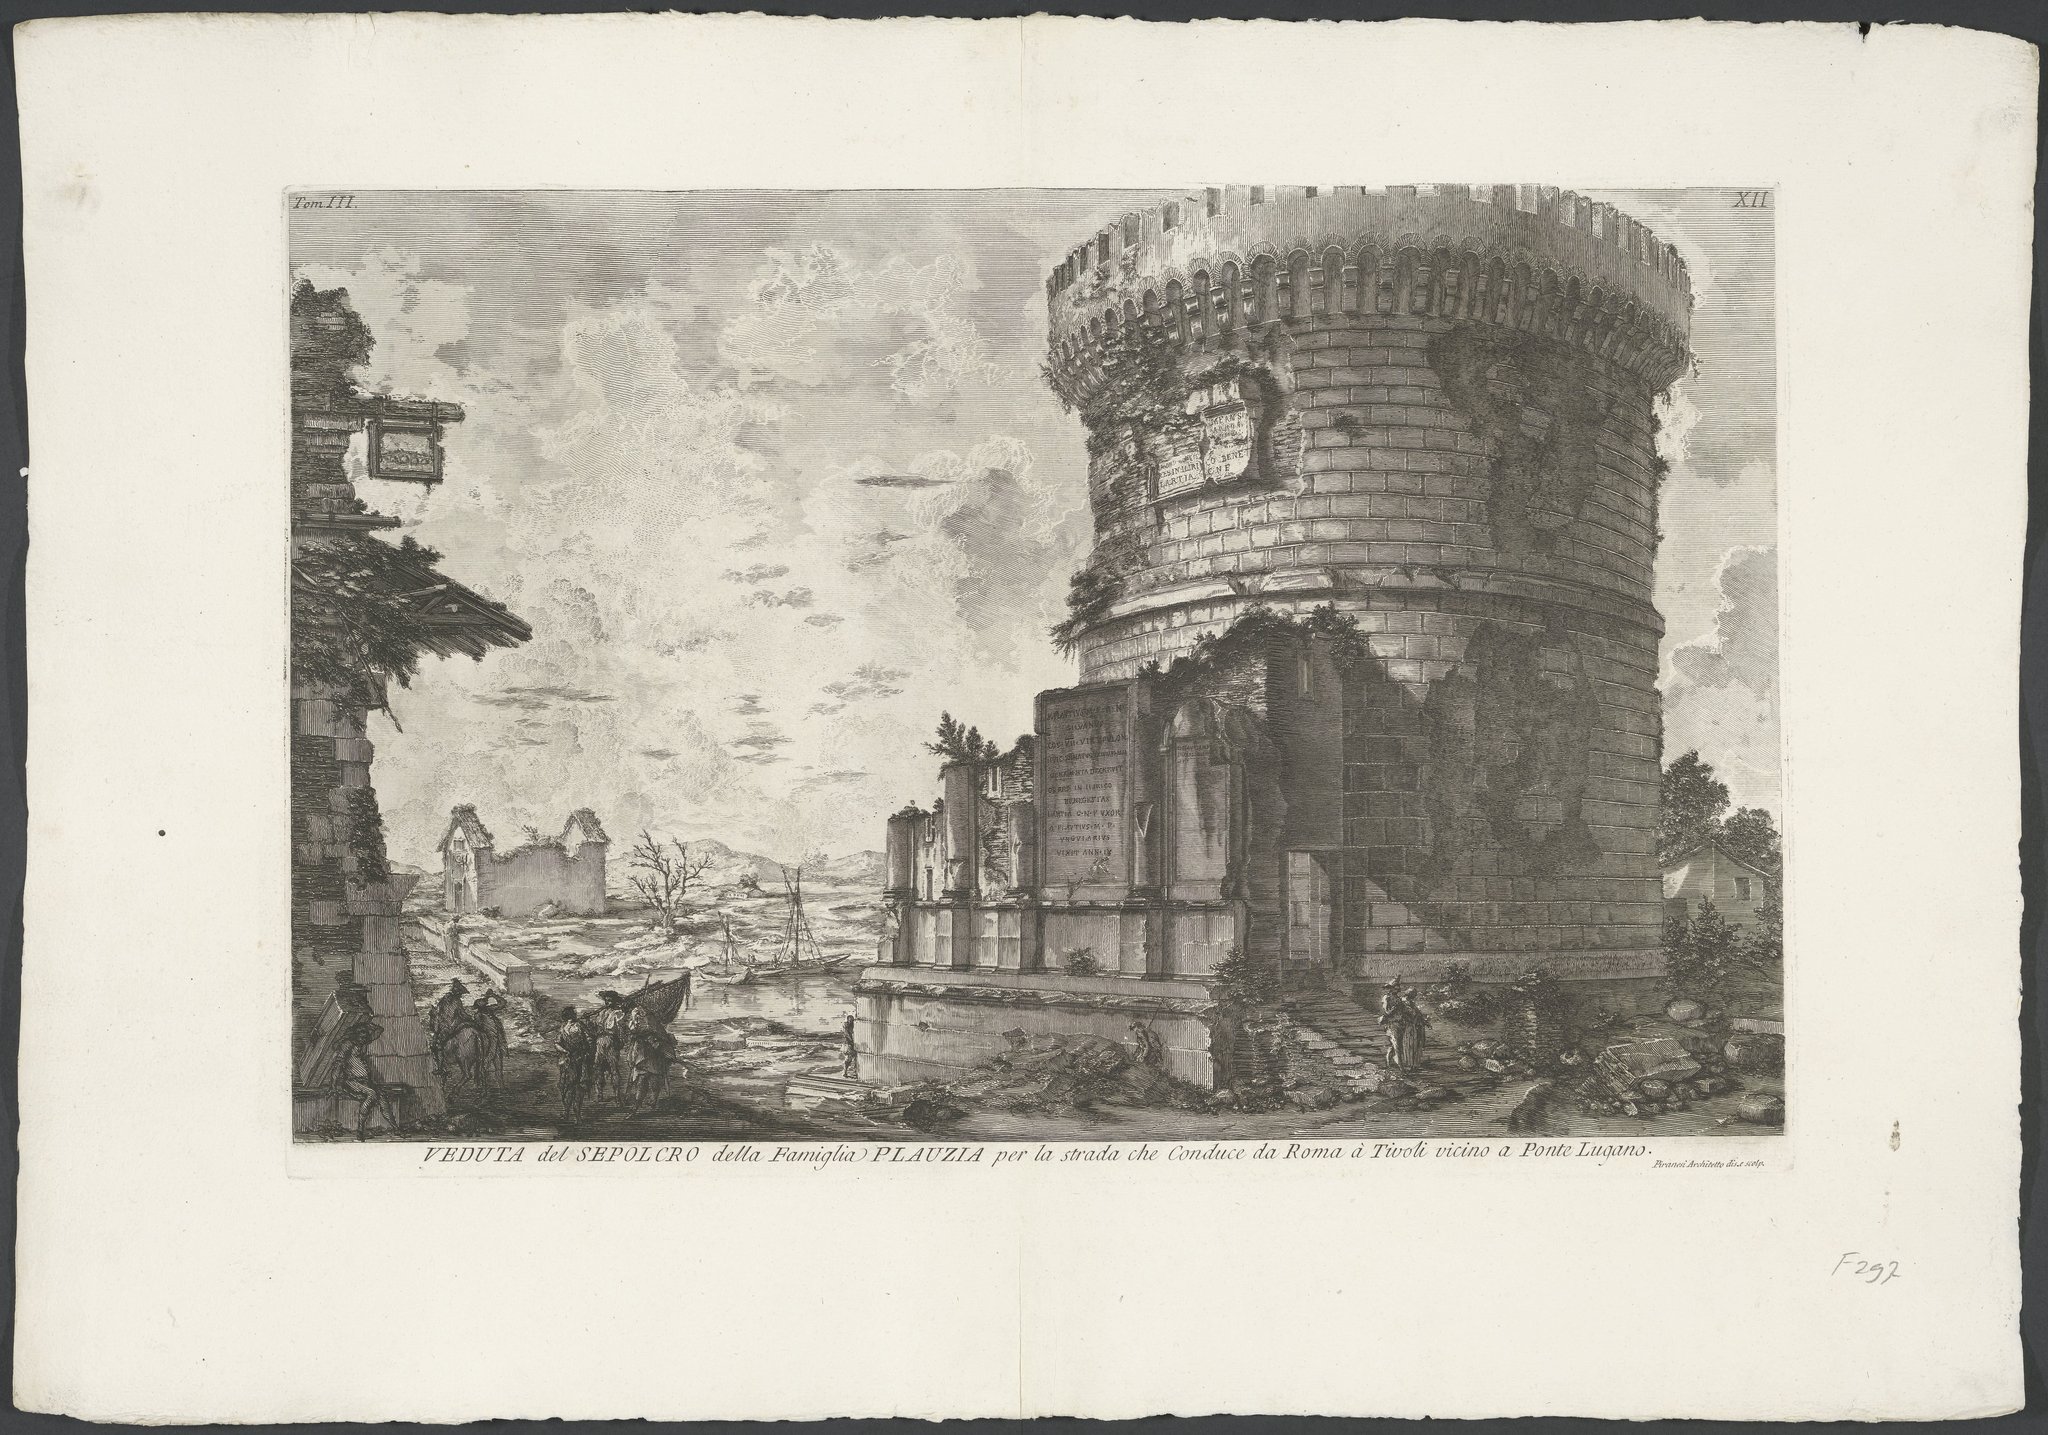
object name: print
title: Veduta del Sepolcro della Famiglia Plauzia per la strada che Conduce da Roma a Tivoli vicino a Ponte Lugano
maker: giovanni battista piranesi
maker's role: designer, draughtsman, print maker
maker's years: 1720-1778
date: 1756-1757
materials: paper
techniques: etching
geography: rome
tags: city-view, and landscape with man-made constructions, ruin of a building ~ architecture, landscape with ruins, grave, tomb, italy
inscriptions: collector's mark: Lugt 2228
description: Deze prent maakt deel uit van de serie 'Le Antichità Romane'. Piranesi deed meer dan acht jaar voorstudie voor deze 250 platen tellende serie die in vier volumes werd uitgegeven. Hij produceerde de prenten tussen ca. 1756 en 1757. De serie bevat ook prenten door of naar andere prentmakers, onder wie Francesco Bianchini en Girolamo Rossi.